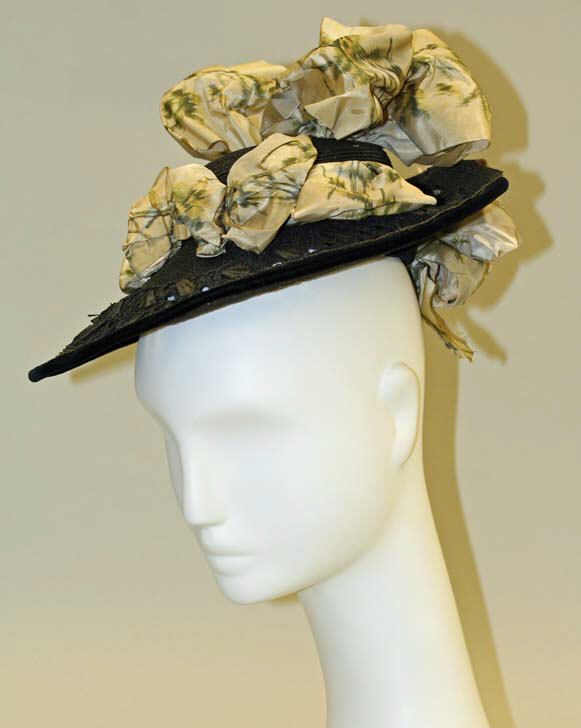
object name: hat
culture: american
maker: h. o'neill & co.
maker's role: designer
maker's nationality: american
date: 1892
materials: silk, fiber